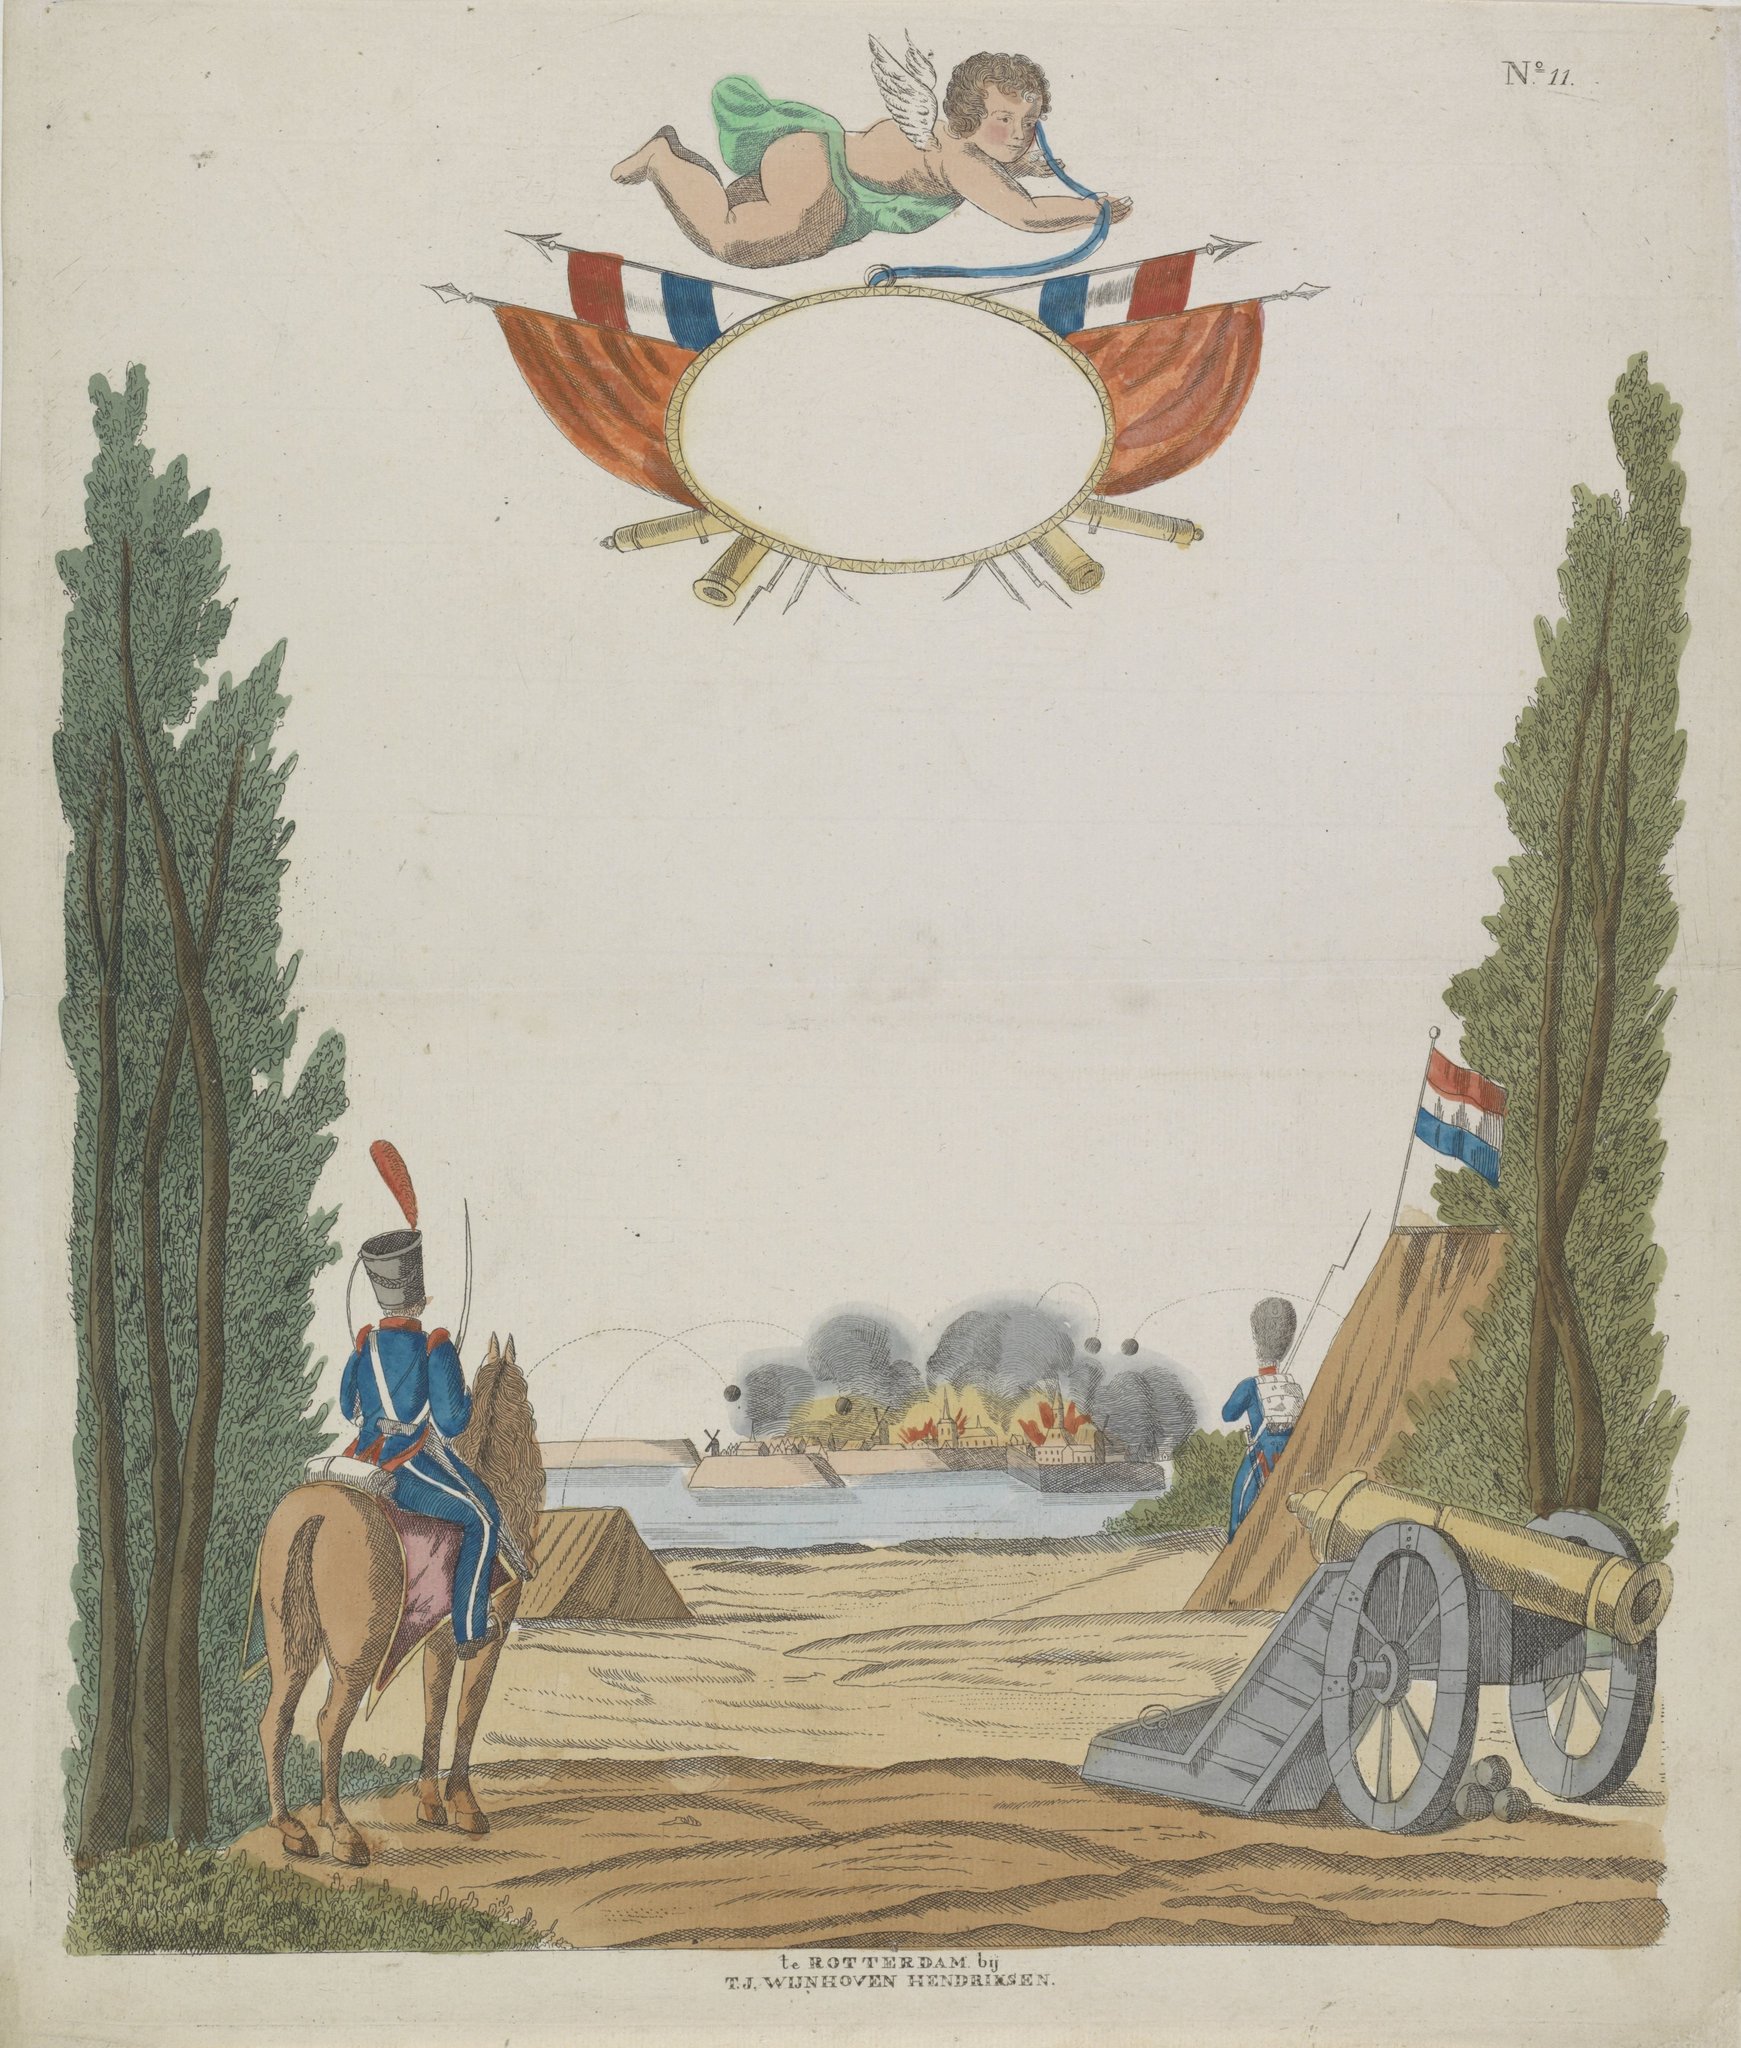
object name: print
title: Wensbrief met soldaten die een stad beschieten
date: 1812-1849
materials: paper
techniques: colour, etching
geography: rotterdam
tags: warfare; military affairs (+ cavalry, horsemen), firearms: cannon, the soldier; the soldier's life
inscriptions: collector's mark: Lugt 2760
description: Wensbrief met onbeschreven cartouche binnen een decoratief kader met een voorstelling van een herder met schapen en een hond. Genummerd rechtsboven: No. 11.